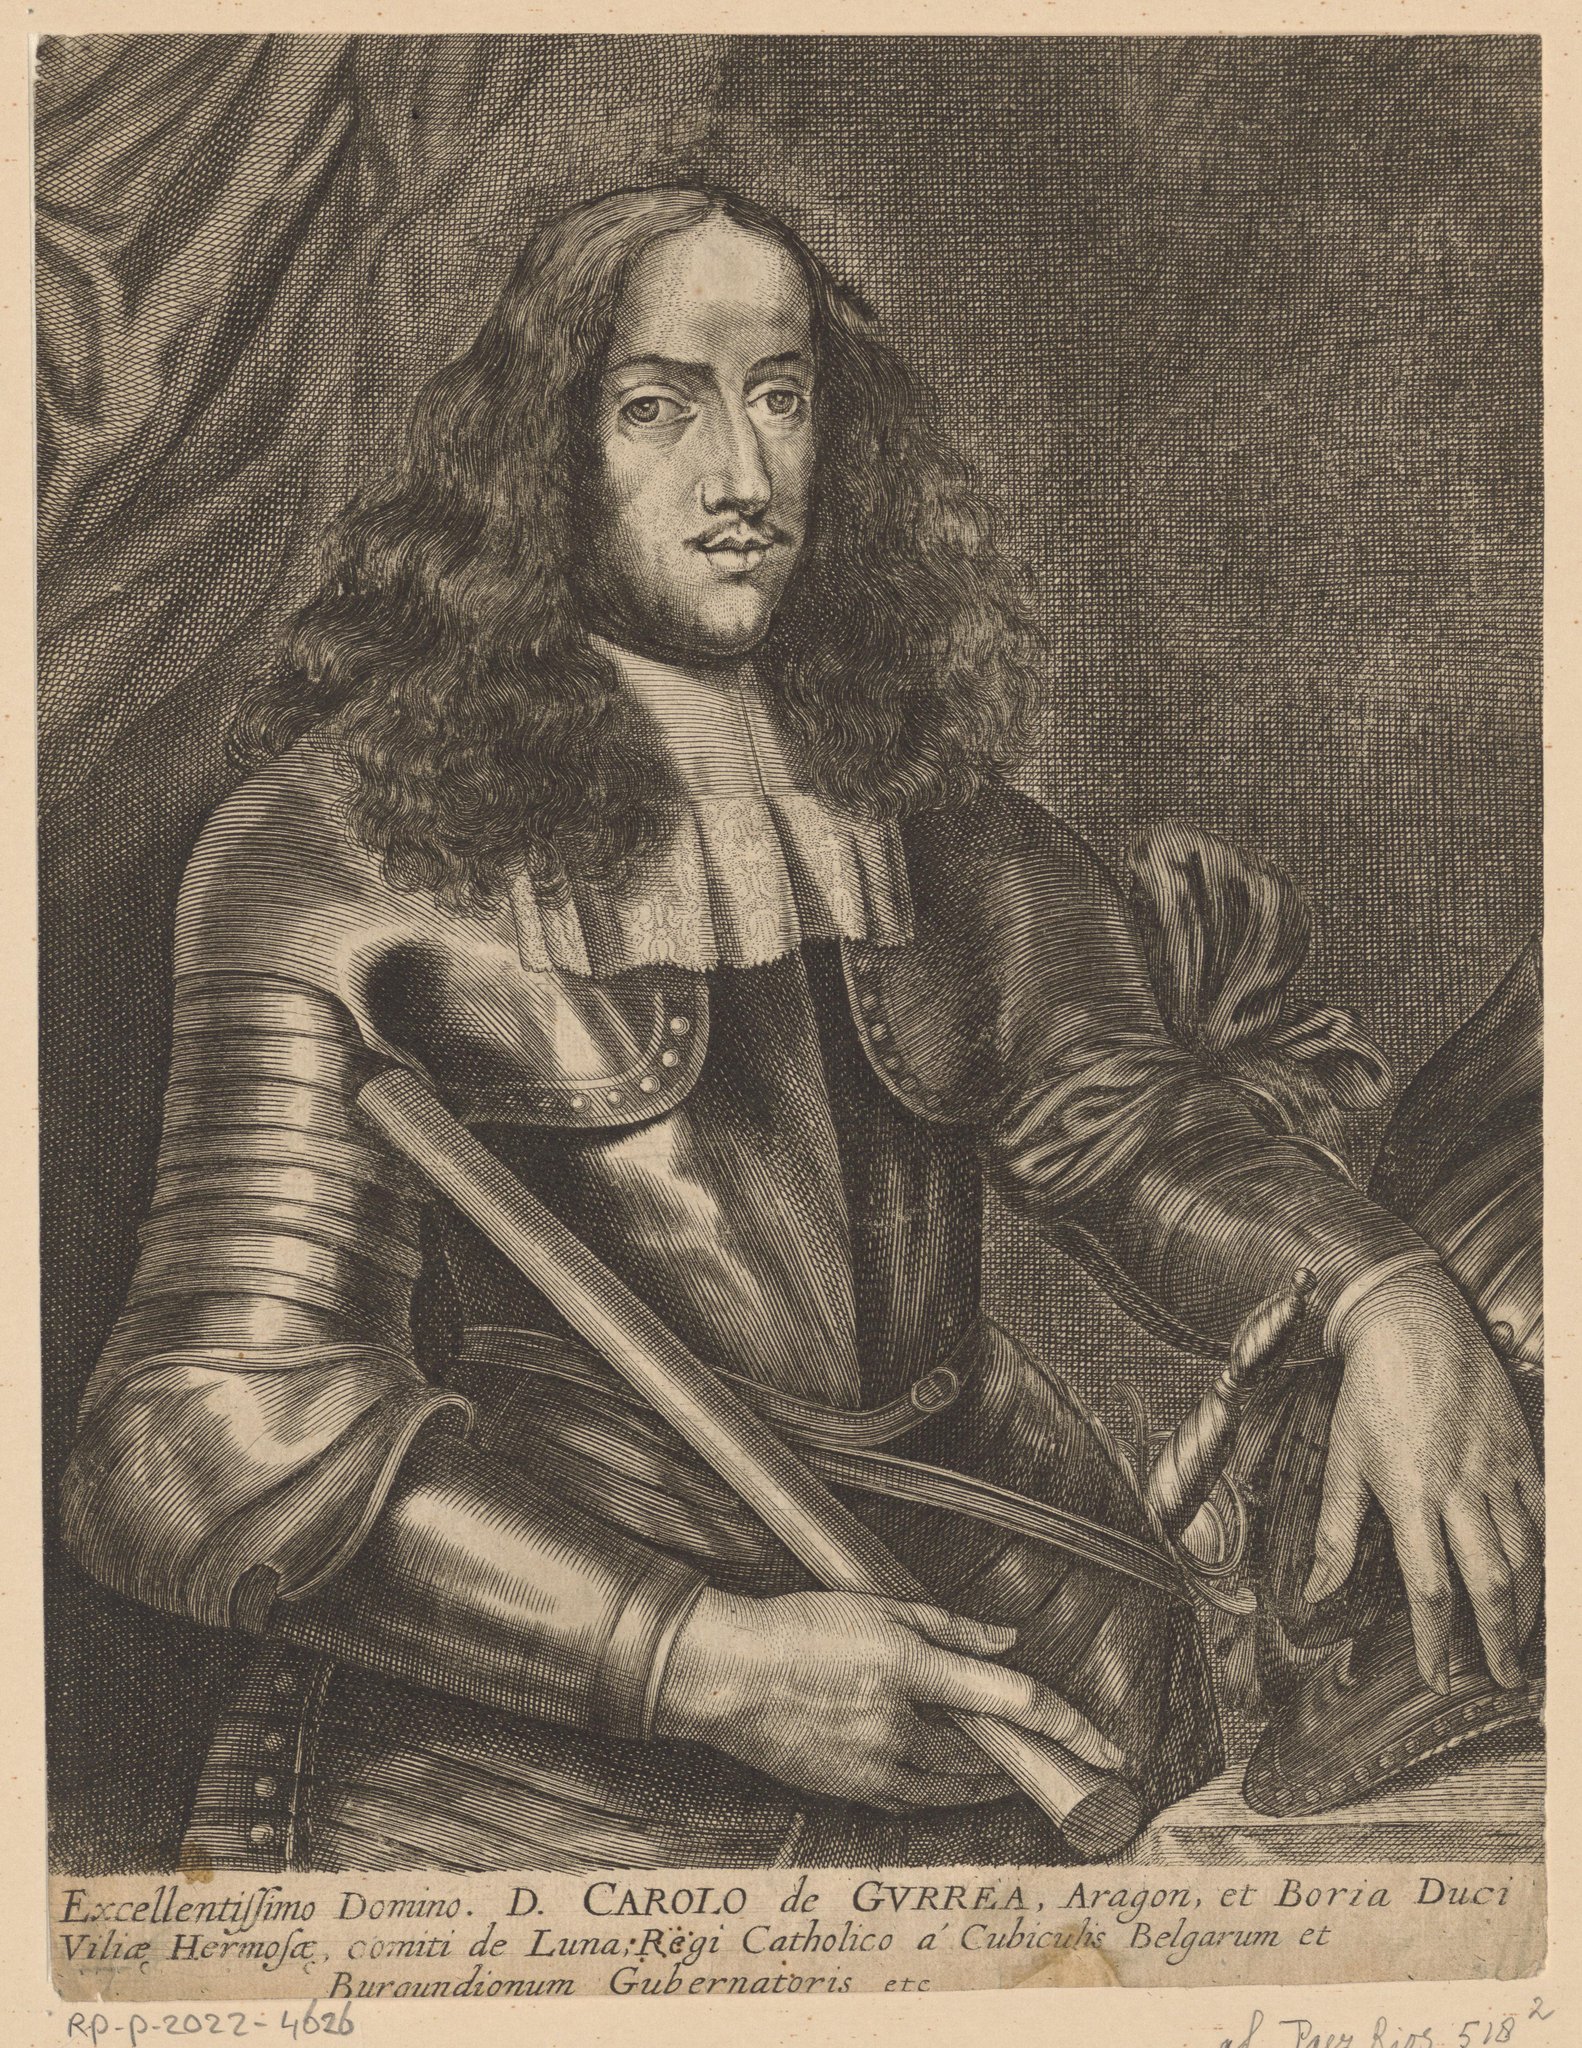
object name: print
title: Portret van Carlos de Gurrea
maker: Anonymous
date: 1675-1700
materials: paper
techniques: engraving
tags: commander-in-chief, general, marshal, armour, historical persons, governor, etc. of province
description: Met drieregelig onderschrift in het Latijn.